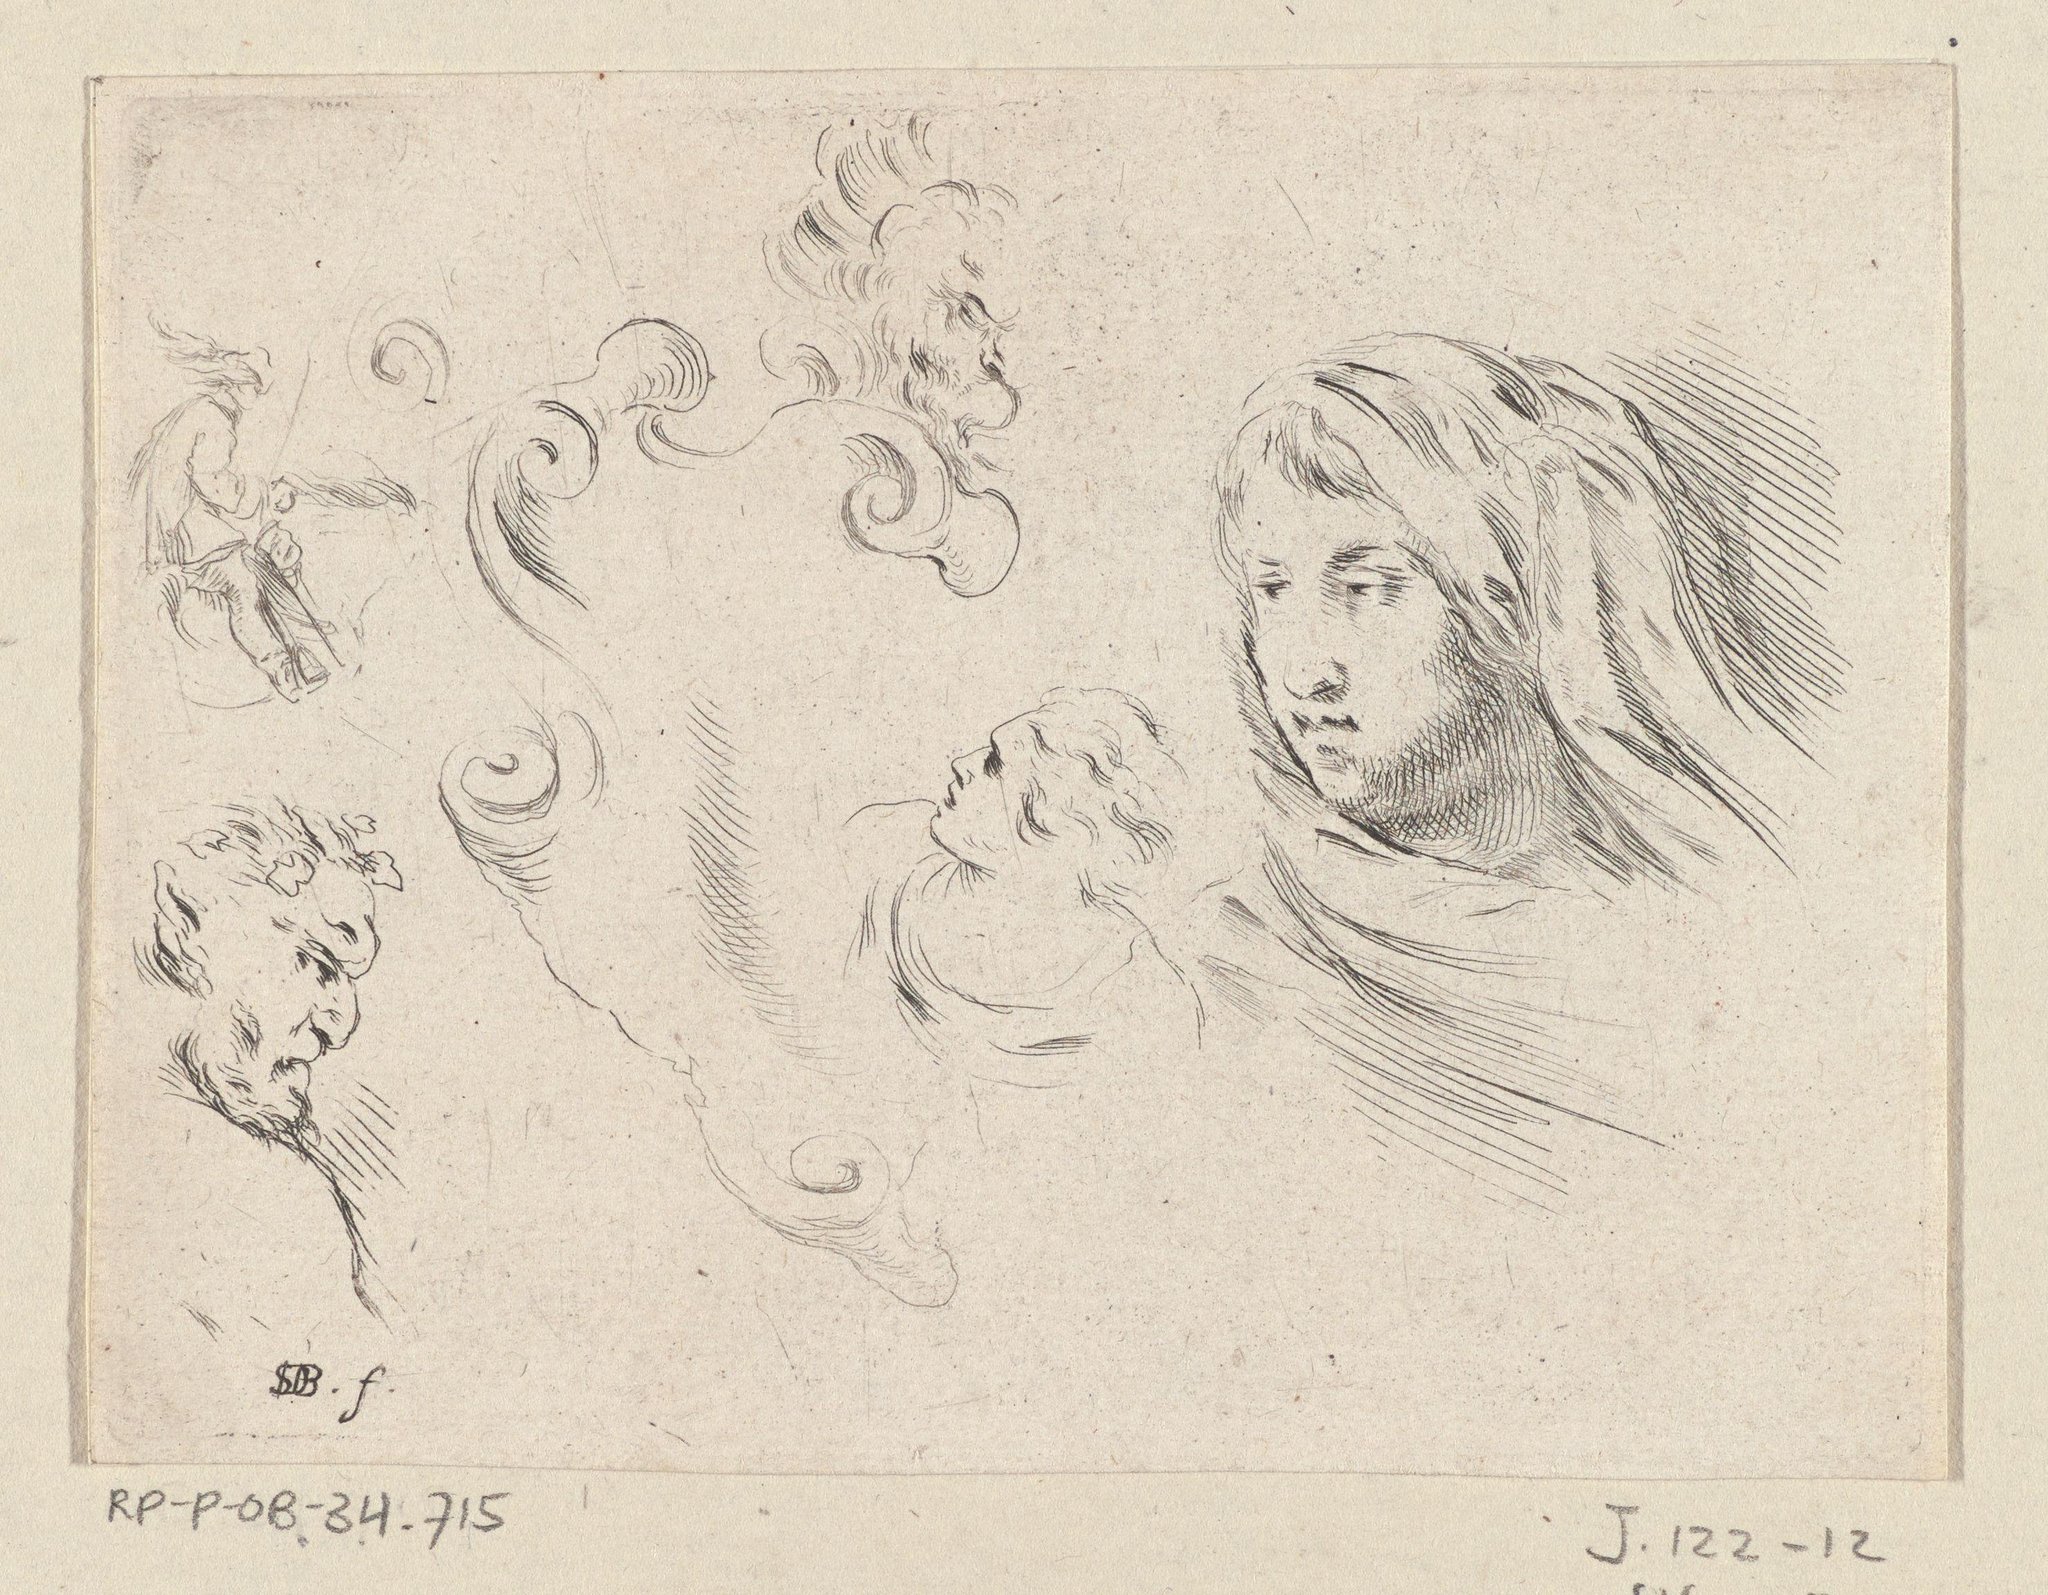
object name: print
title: Hoofd van een gesluierde vrouw, hoofd van een man, hoofd van een sater, een krulornament en een man te paard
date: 1620-1664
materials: paper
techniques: etching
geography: paris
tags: riding a horse, ass, or mule; rider, horseman, adult woman, adult man, satyr(s) (in general)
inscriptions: collector's mark: Lugt 240